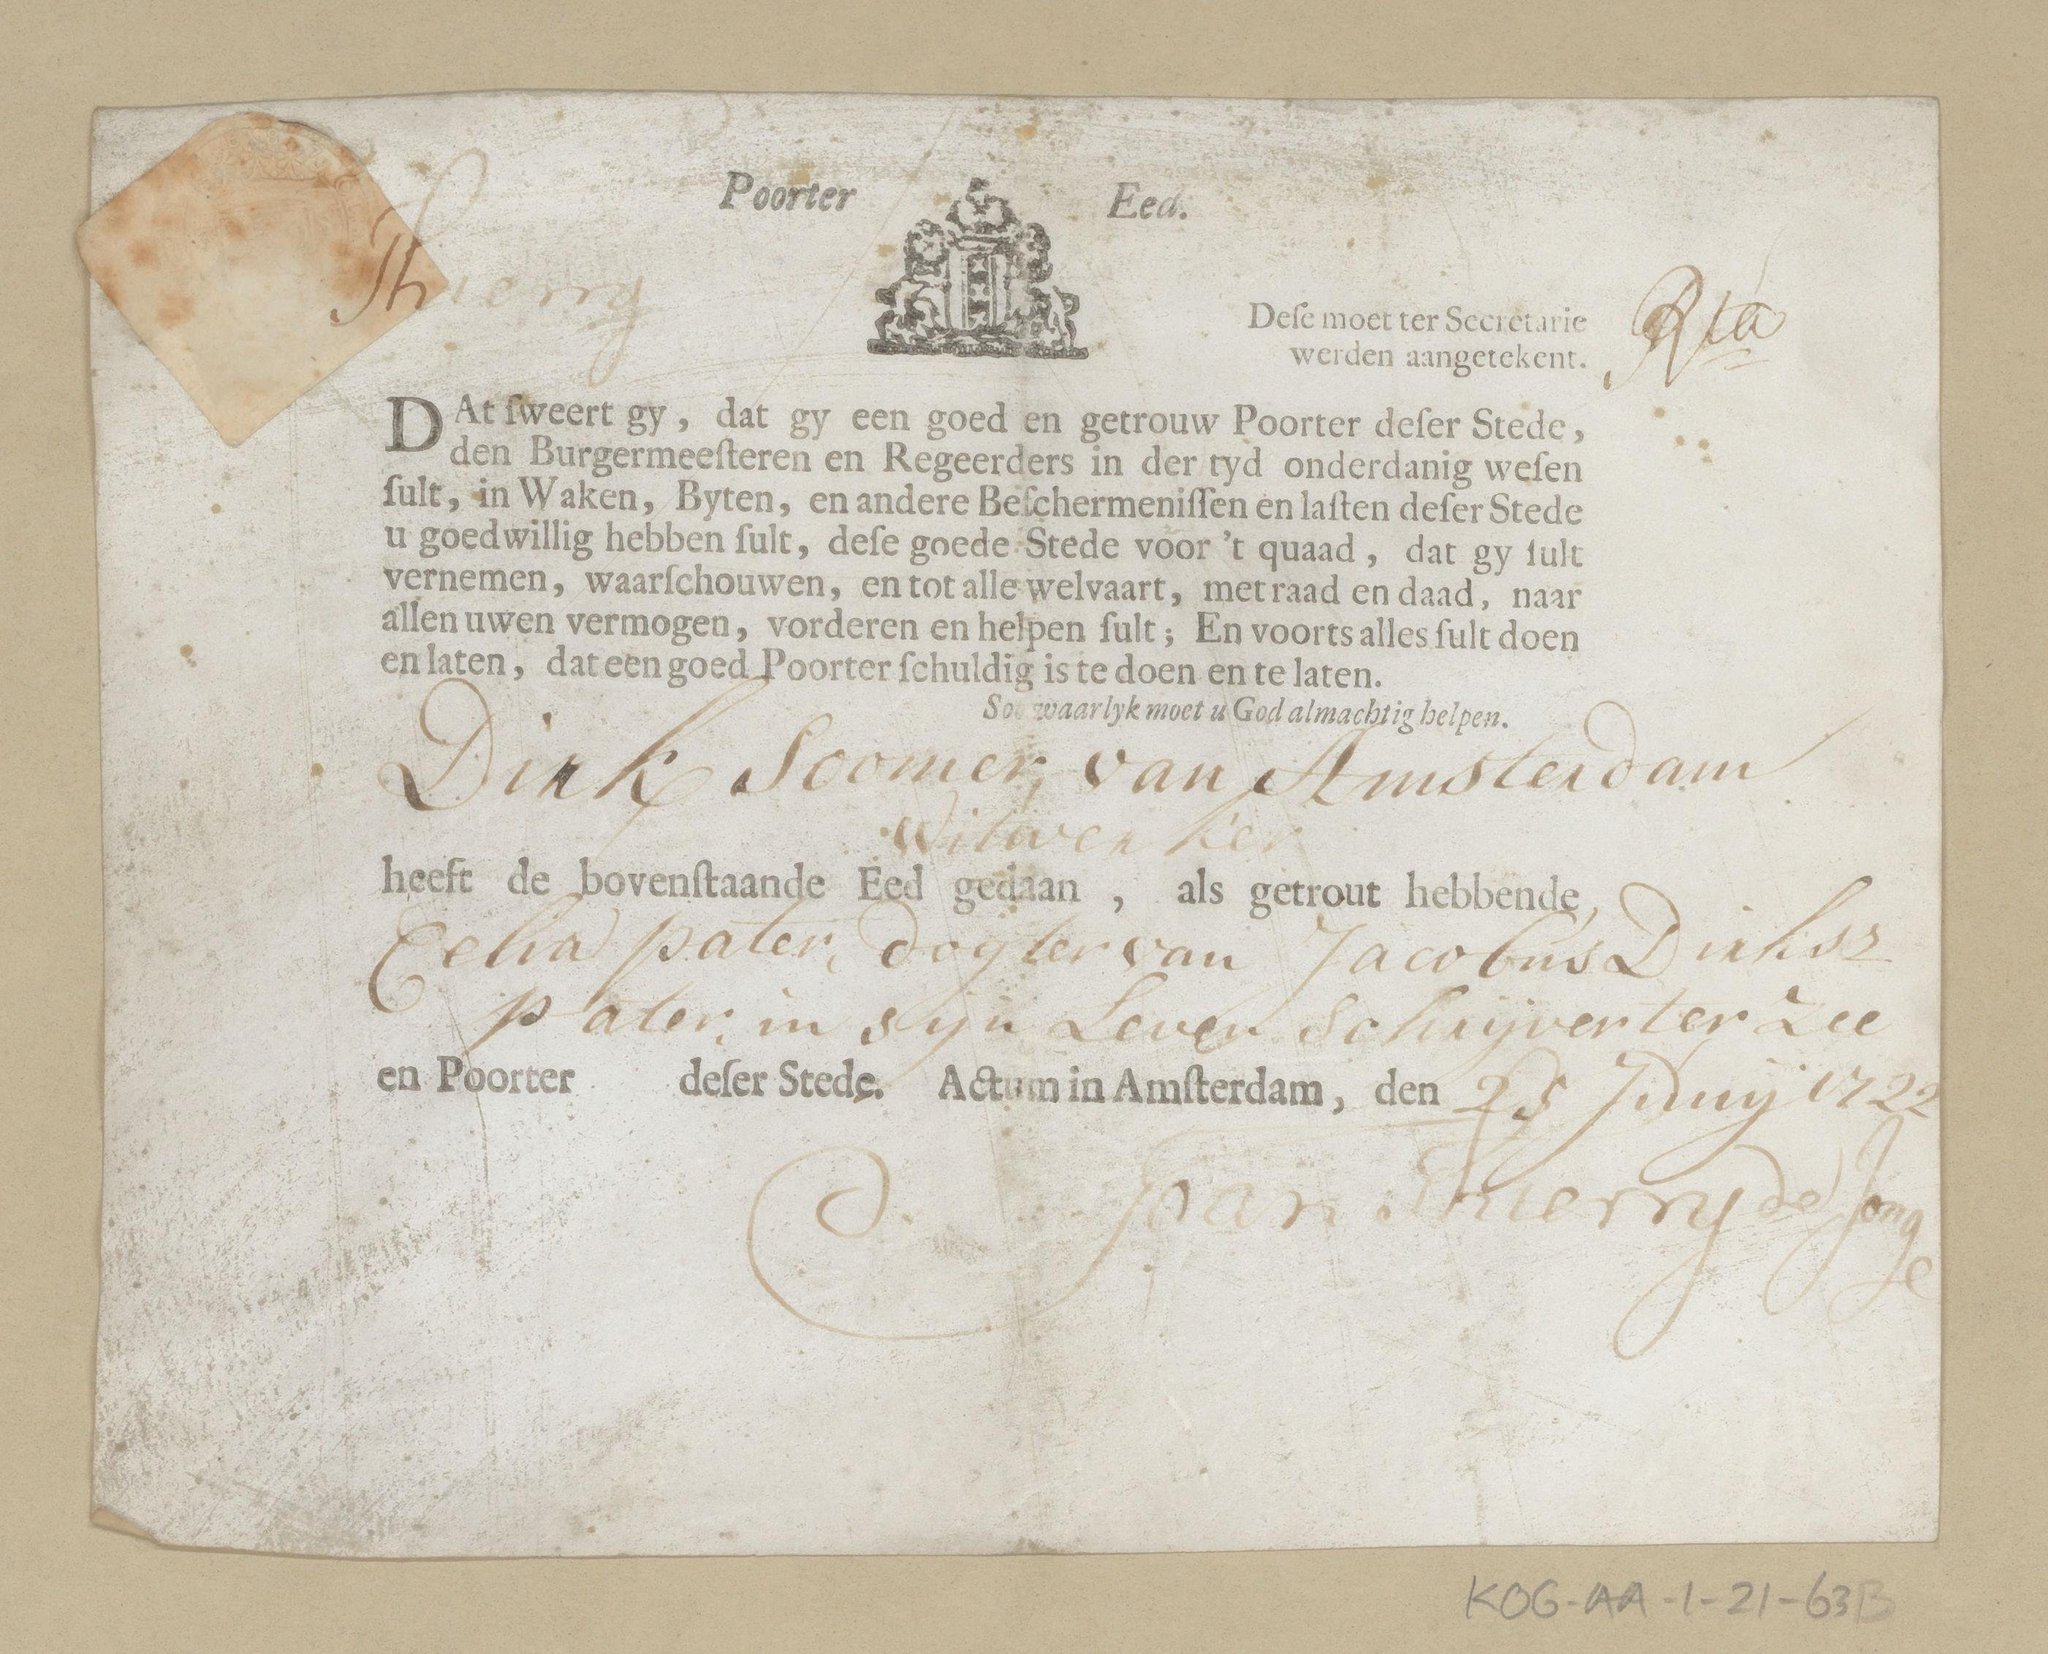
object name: document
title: Poorter Eed van Dirk Soomer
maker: joan thierry de jonge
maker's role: secretaris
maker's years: 1699-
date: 1777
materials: ink, parchment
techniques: blind stamped, letterpress printing, pen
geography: amsterdam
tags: coat of arms (as symbol of the state, etc.) (+ city; municipal), bourgeoisie, middle class, citizens, burghers, amsterdam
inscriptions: check stamp: ‘Clein Segel 1752 3 St, wapen van Holland’, collector's mark: Lugt 1641b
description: Onderwerpsrubriek binnen de Atlas Amsterdam: Poorterbriefjes.